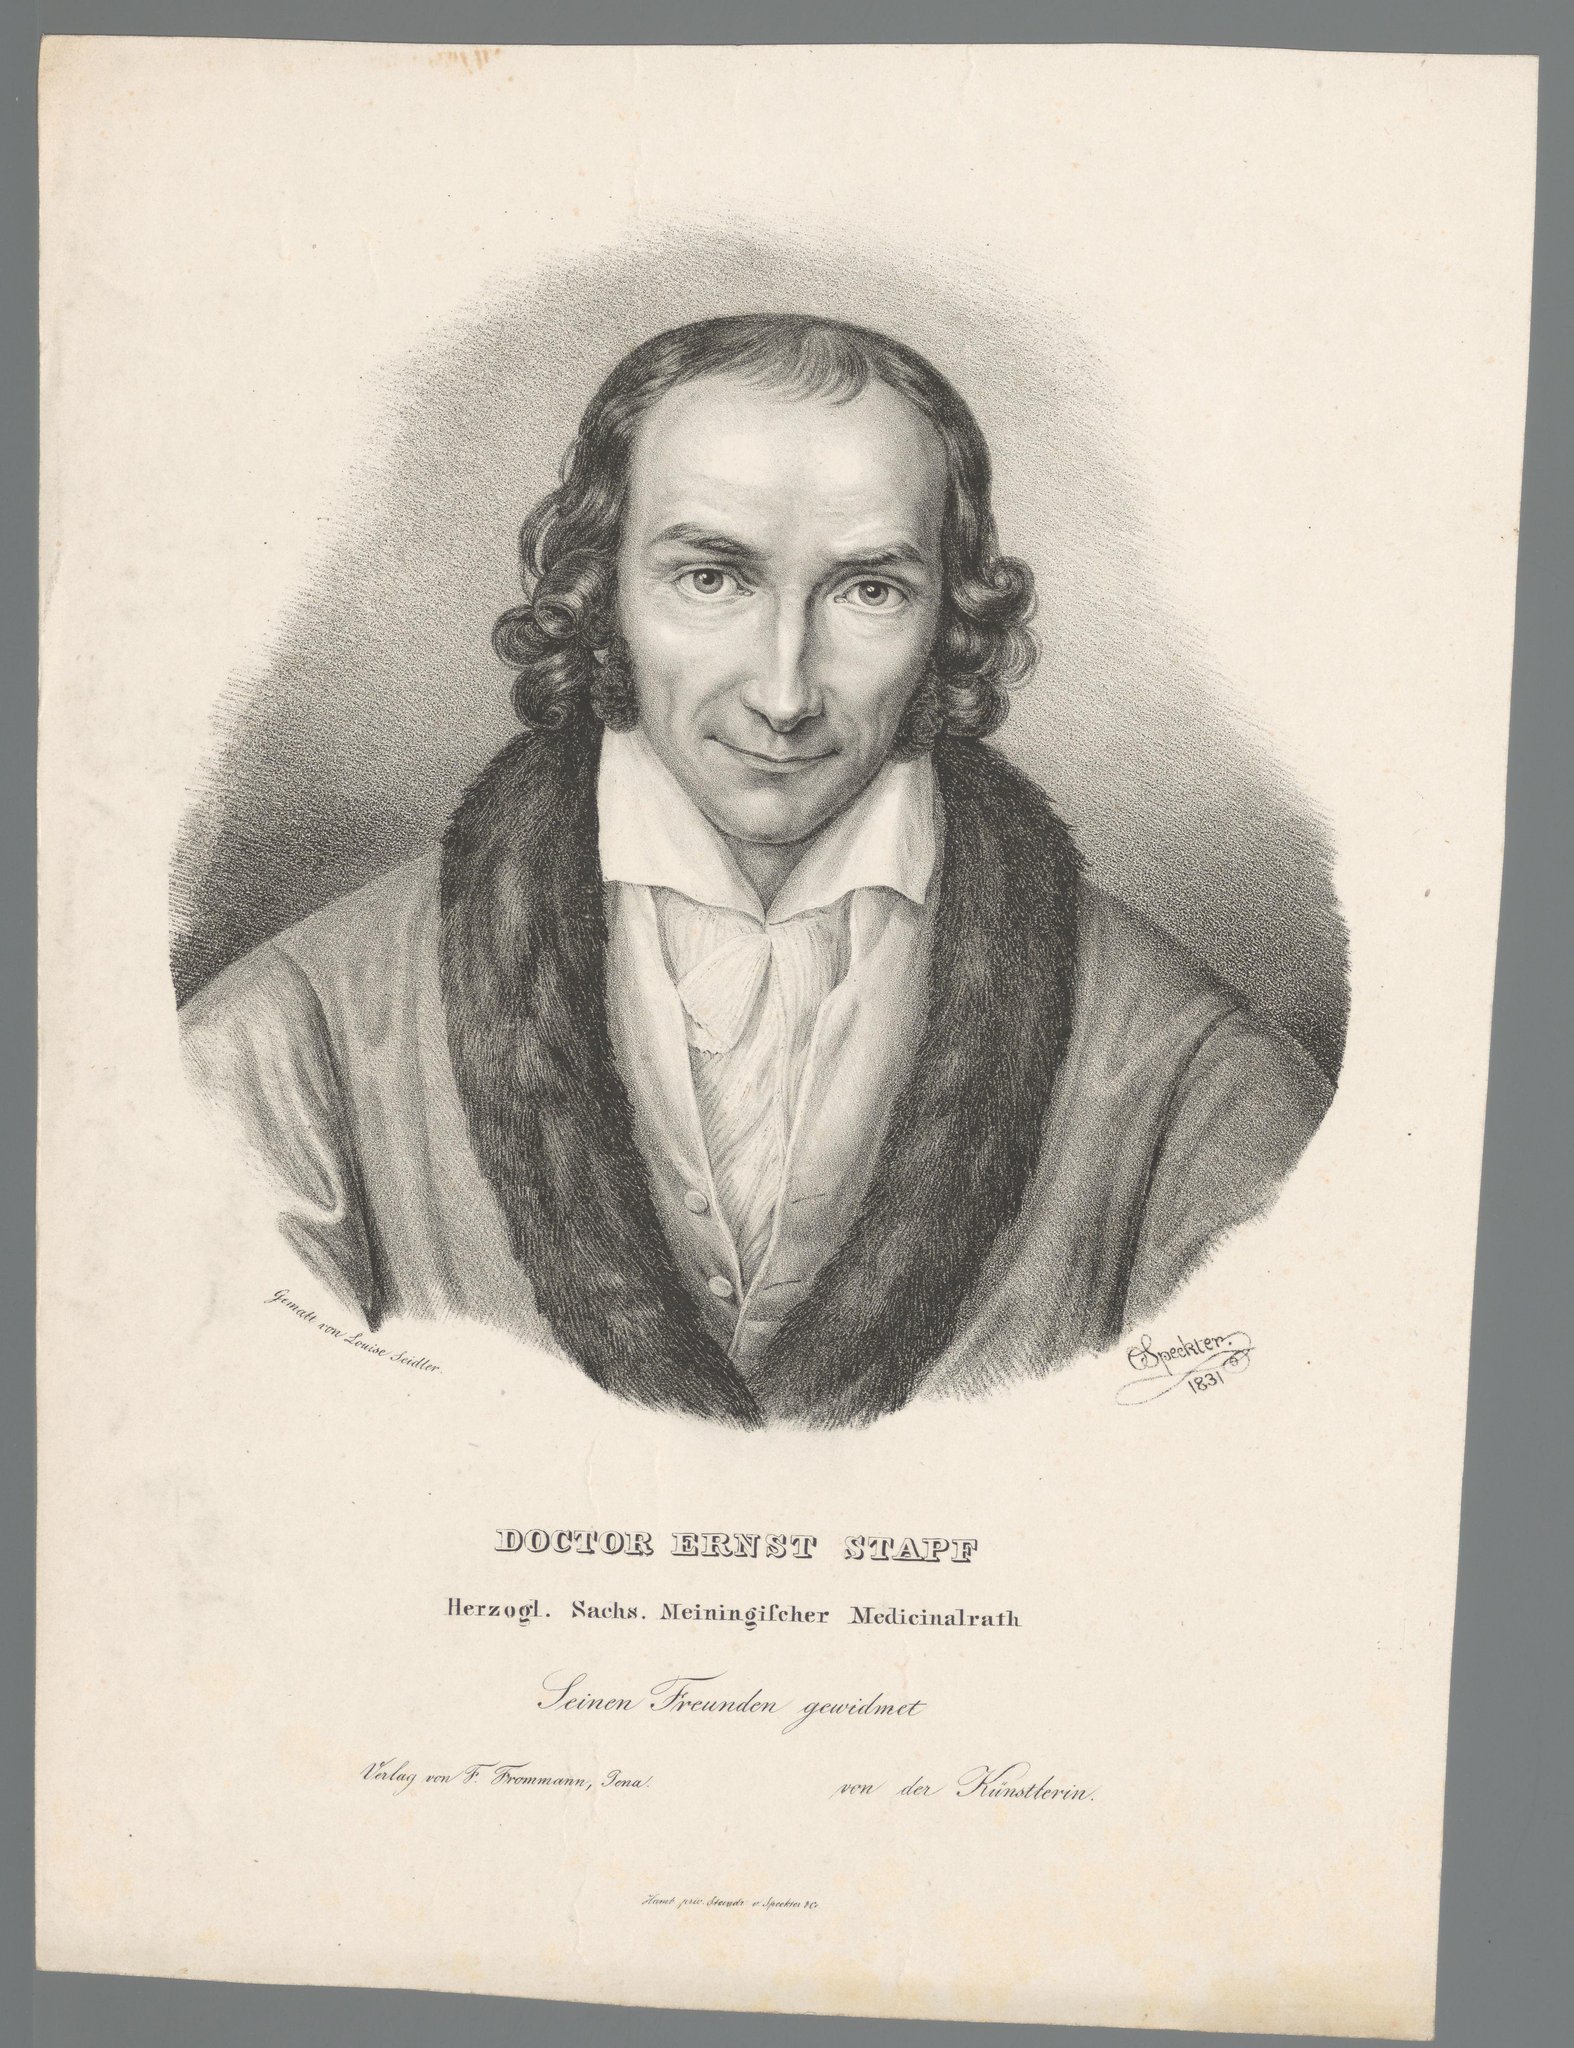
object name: print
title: Portret van Johann Ernst Stapf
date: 1831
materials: paper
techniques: lithograph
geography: hamburg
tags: adult man, historical persons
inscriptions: collector's mark: Lugt 2228